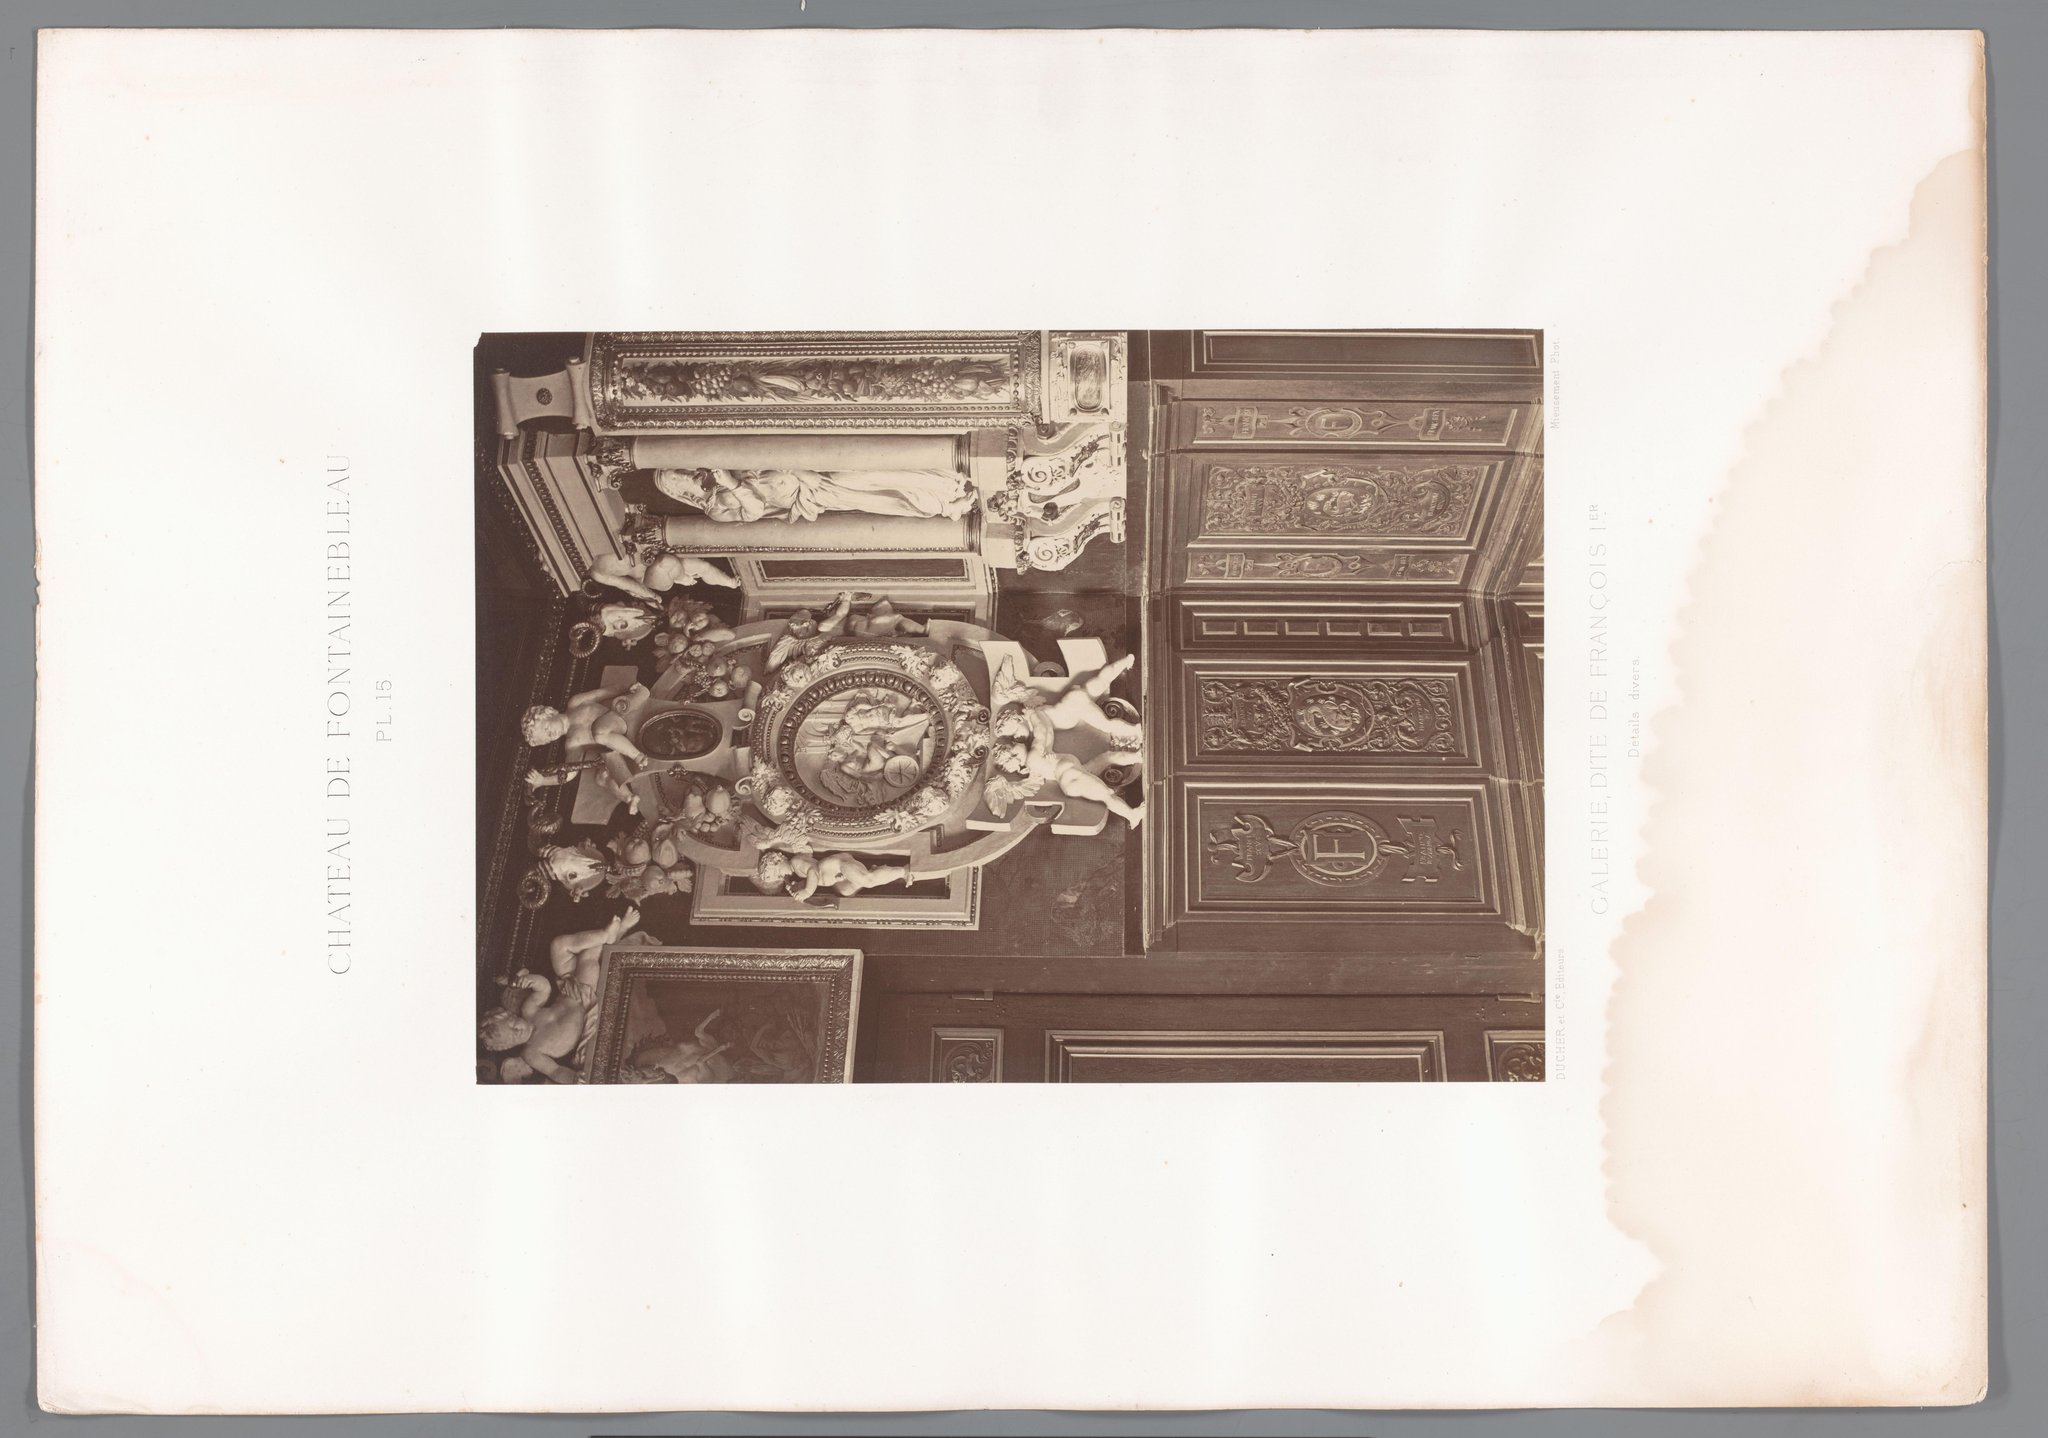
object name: photograph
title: Chateau de Fontainebleau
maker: séraphin-médéric mieusement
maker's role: fotograaf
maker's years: 1840-1905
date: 1870-1875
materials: photographic support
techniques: albumen print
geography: fontainebleau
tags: castle - aa - civic architecture: inside, panelling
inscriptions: number: ‘PL. 15.’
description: Deze foto maakt deel uit van een omslag met dertig foto's en twee tekstbladen.